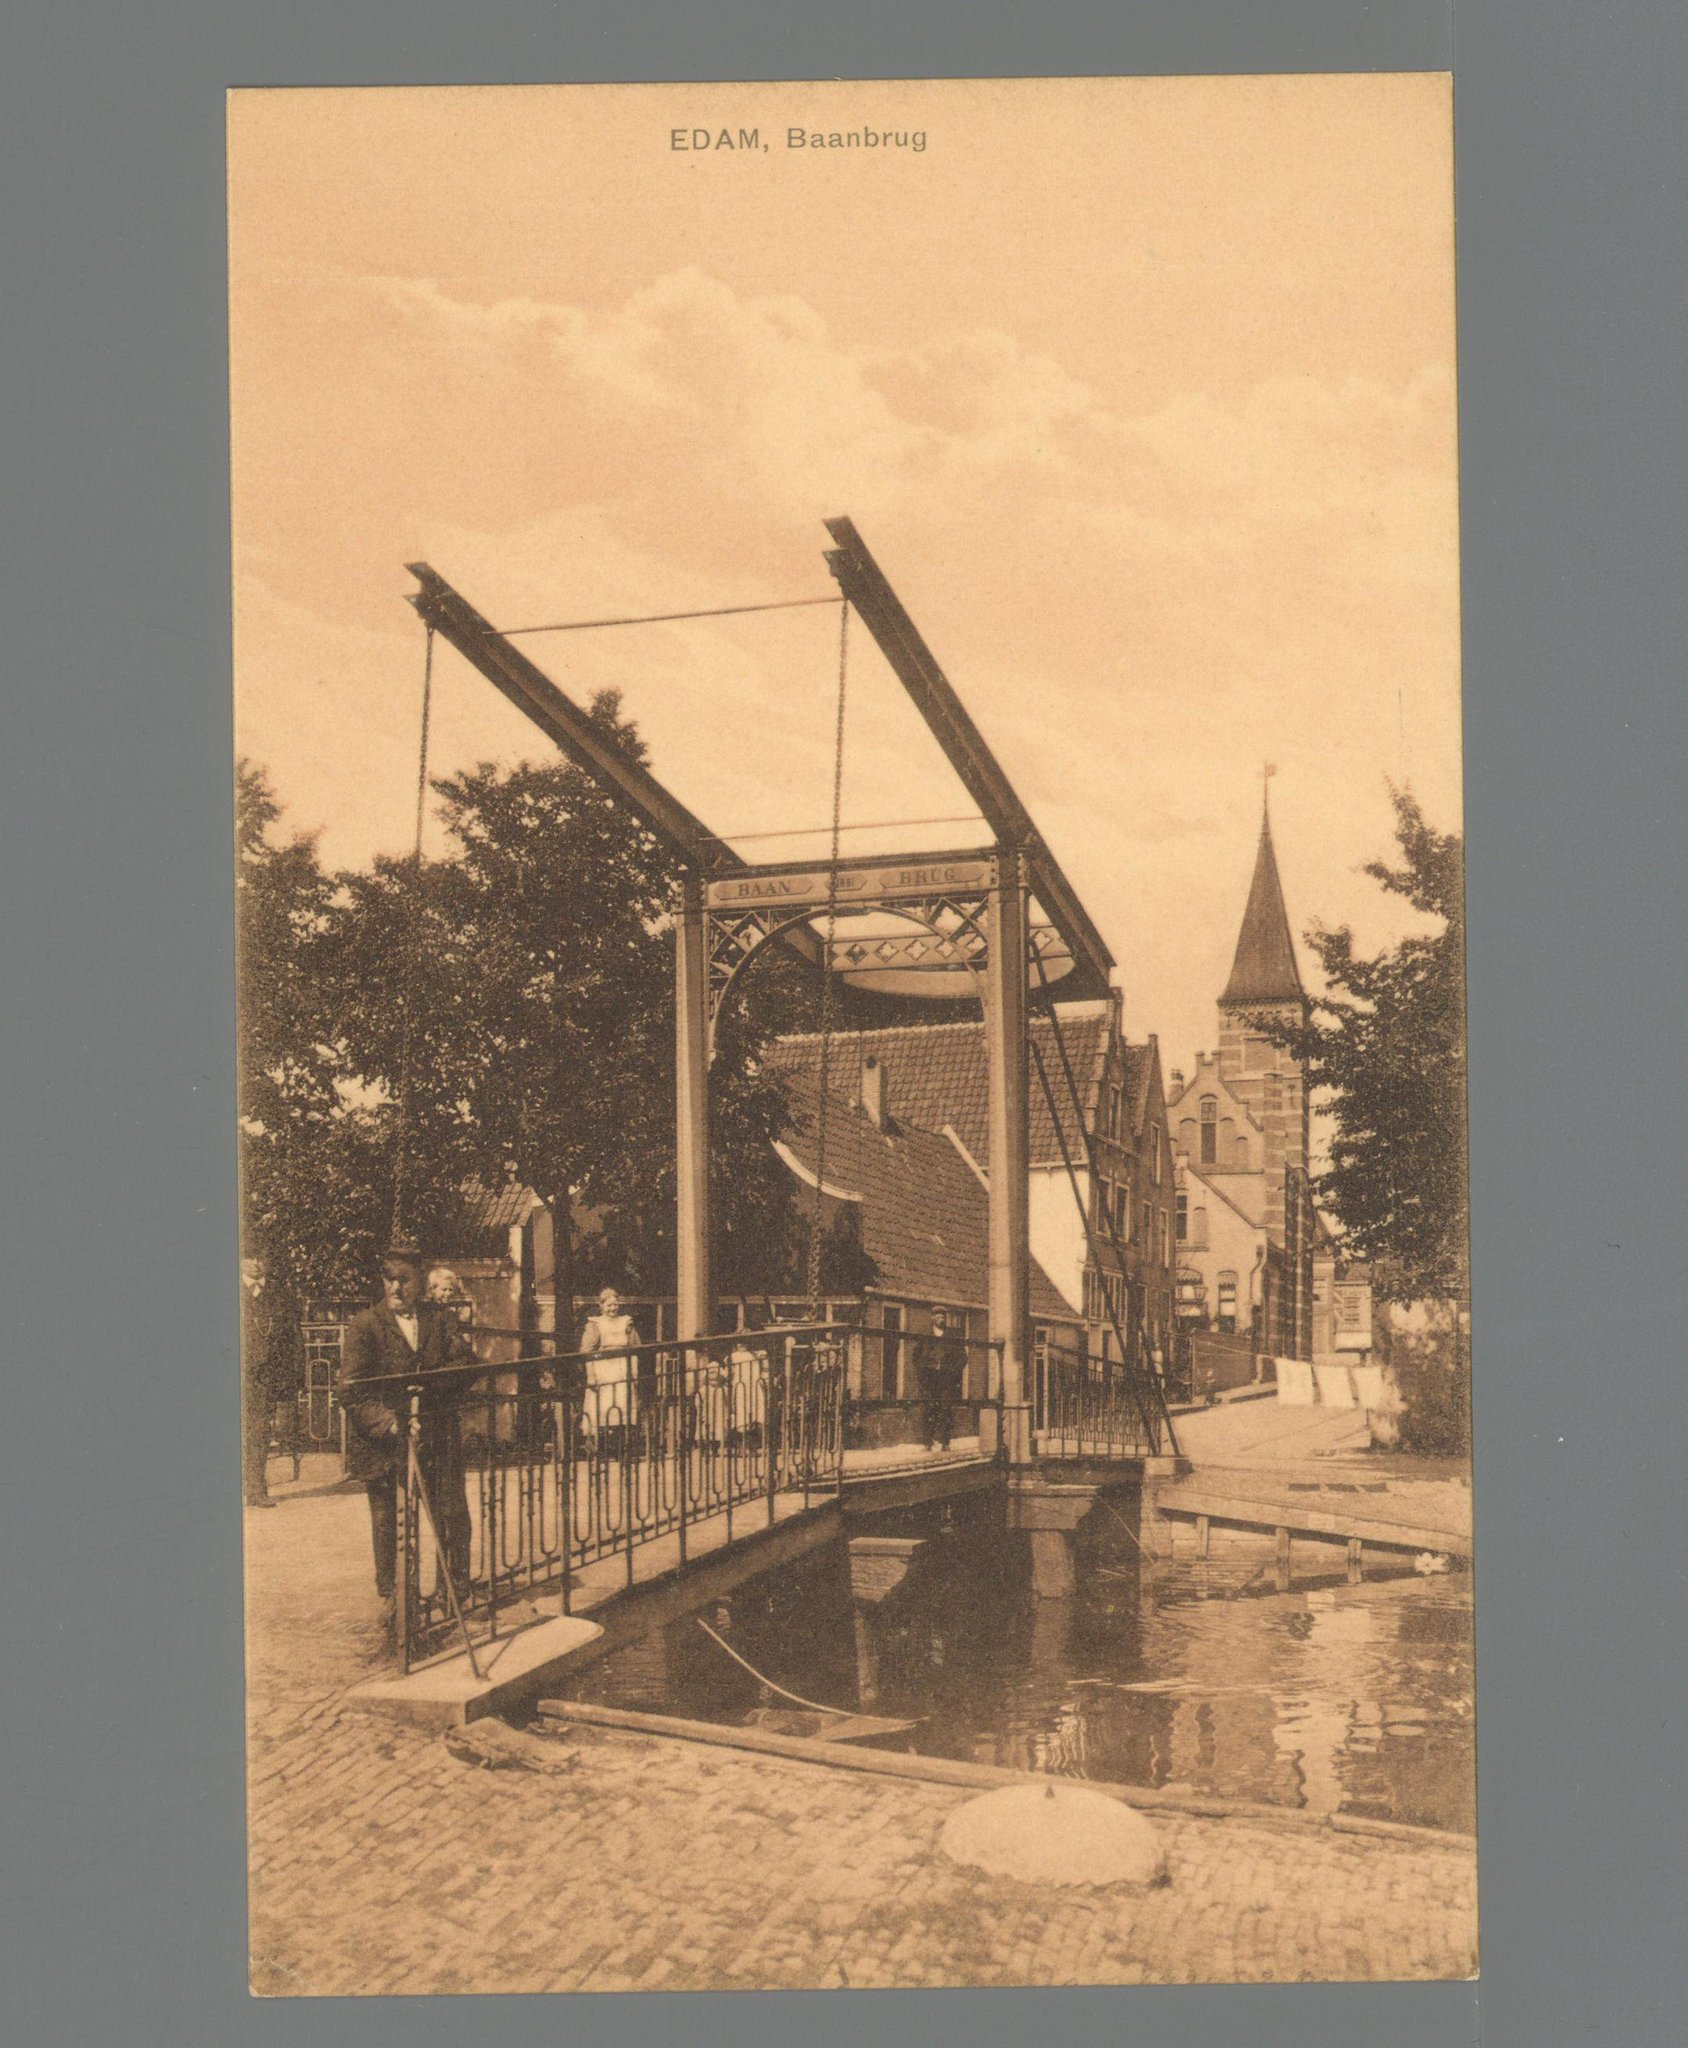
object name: ansichtkaart, prentbriefkaart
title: Edam, Baanbrug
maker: Anonymous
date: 1906-1930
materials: cardboard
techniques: photograph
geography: edam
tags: city-view, and landscape with man-made constructions, canals, waters (in city), bridge in city across river, canal, etc.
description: Mogelijk gedateerd 1919 op verso, eerste twee cijfers van het getal.